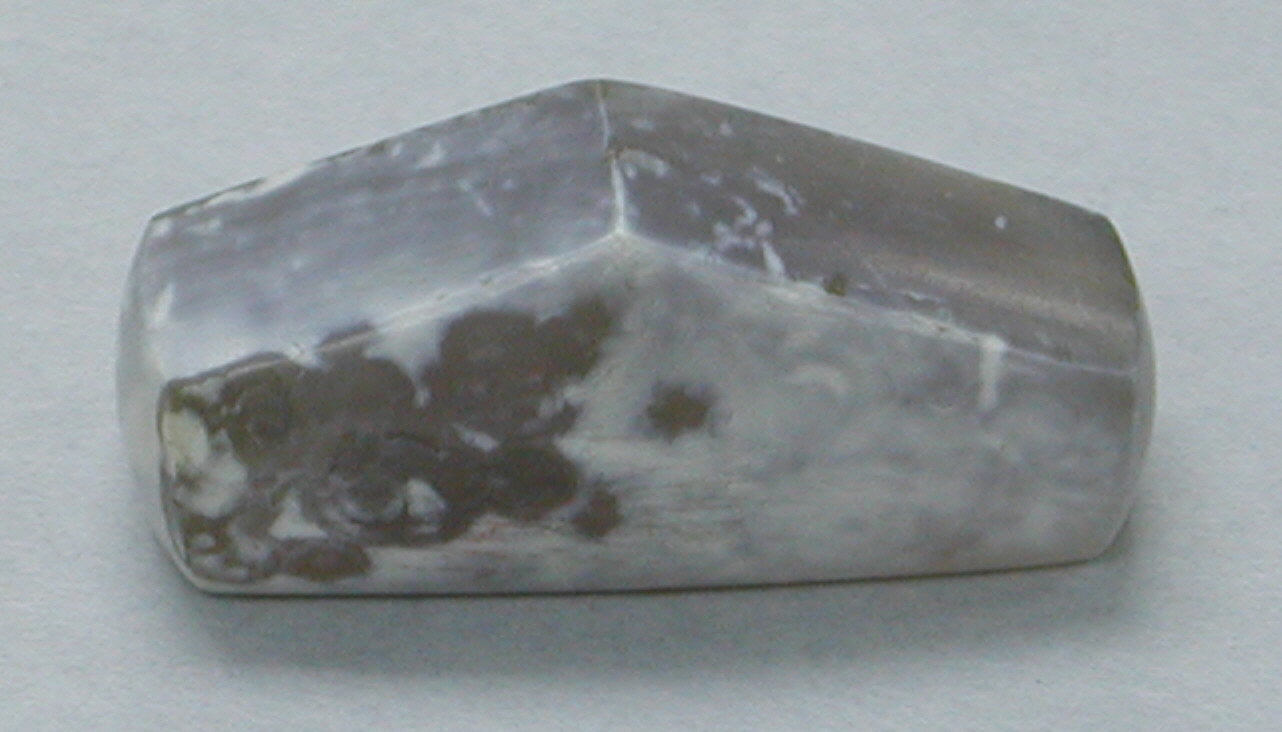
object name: ritual stone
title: Stone Pulidor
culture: mexican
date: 1501-1600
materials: stone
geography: mexico